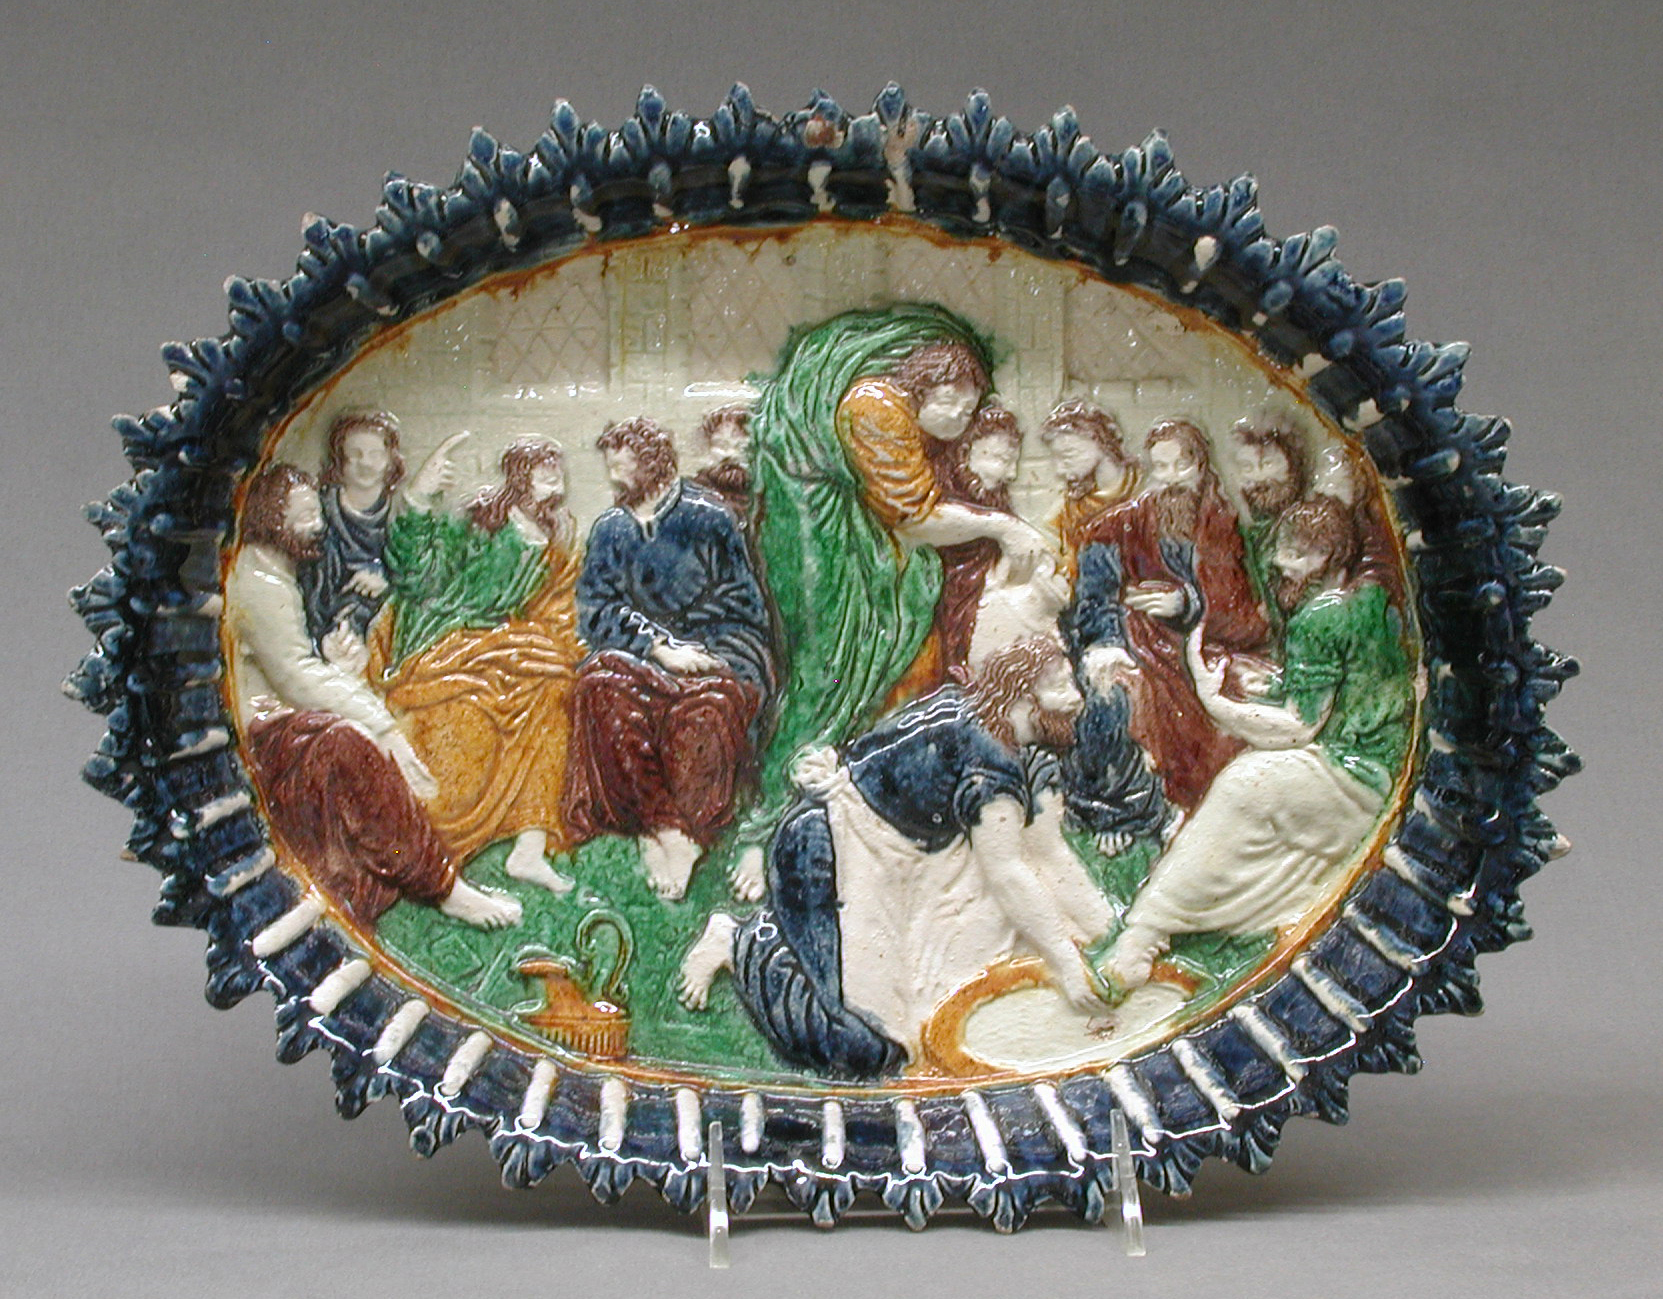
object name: dish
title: Dish with Christ washing the feet of St. Peter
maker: bernard palissy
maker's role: maker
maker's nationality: french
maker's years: 1510-1590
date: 1651-1700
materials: earthenware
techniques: glazing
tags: men,christ,saint peter